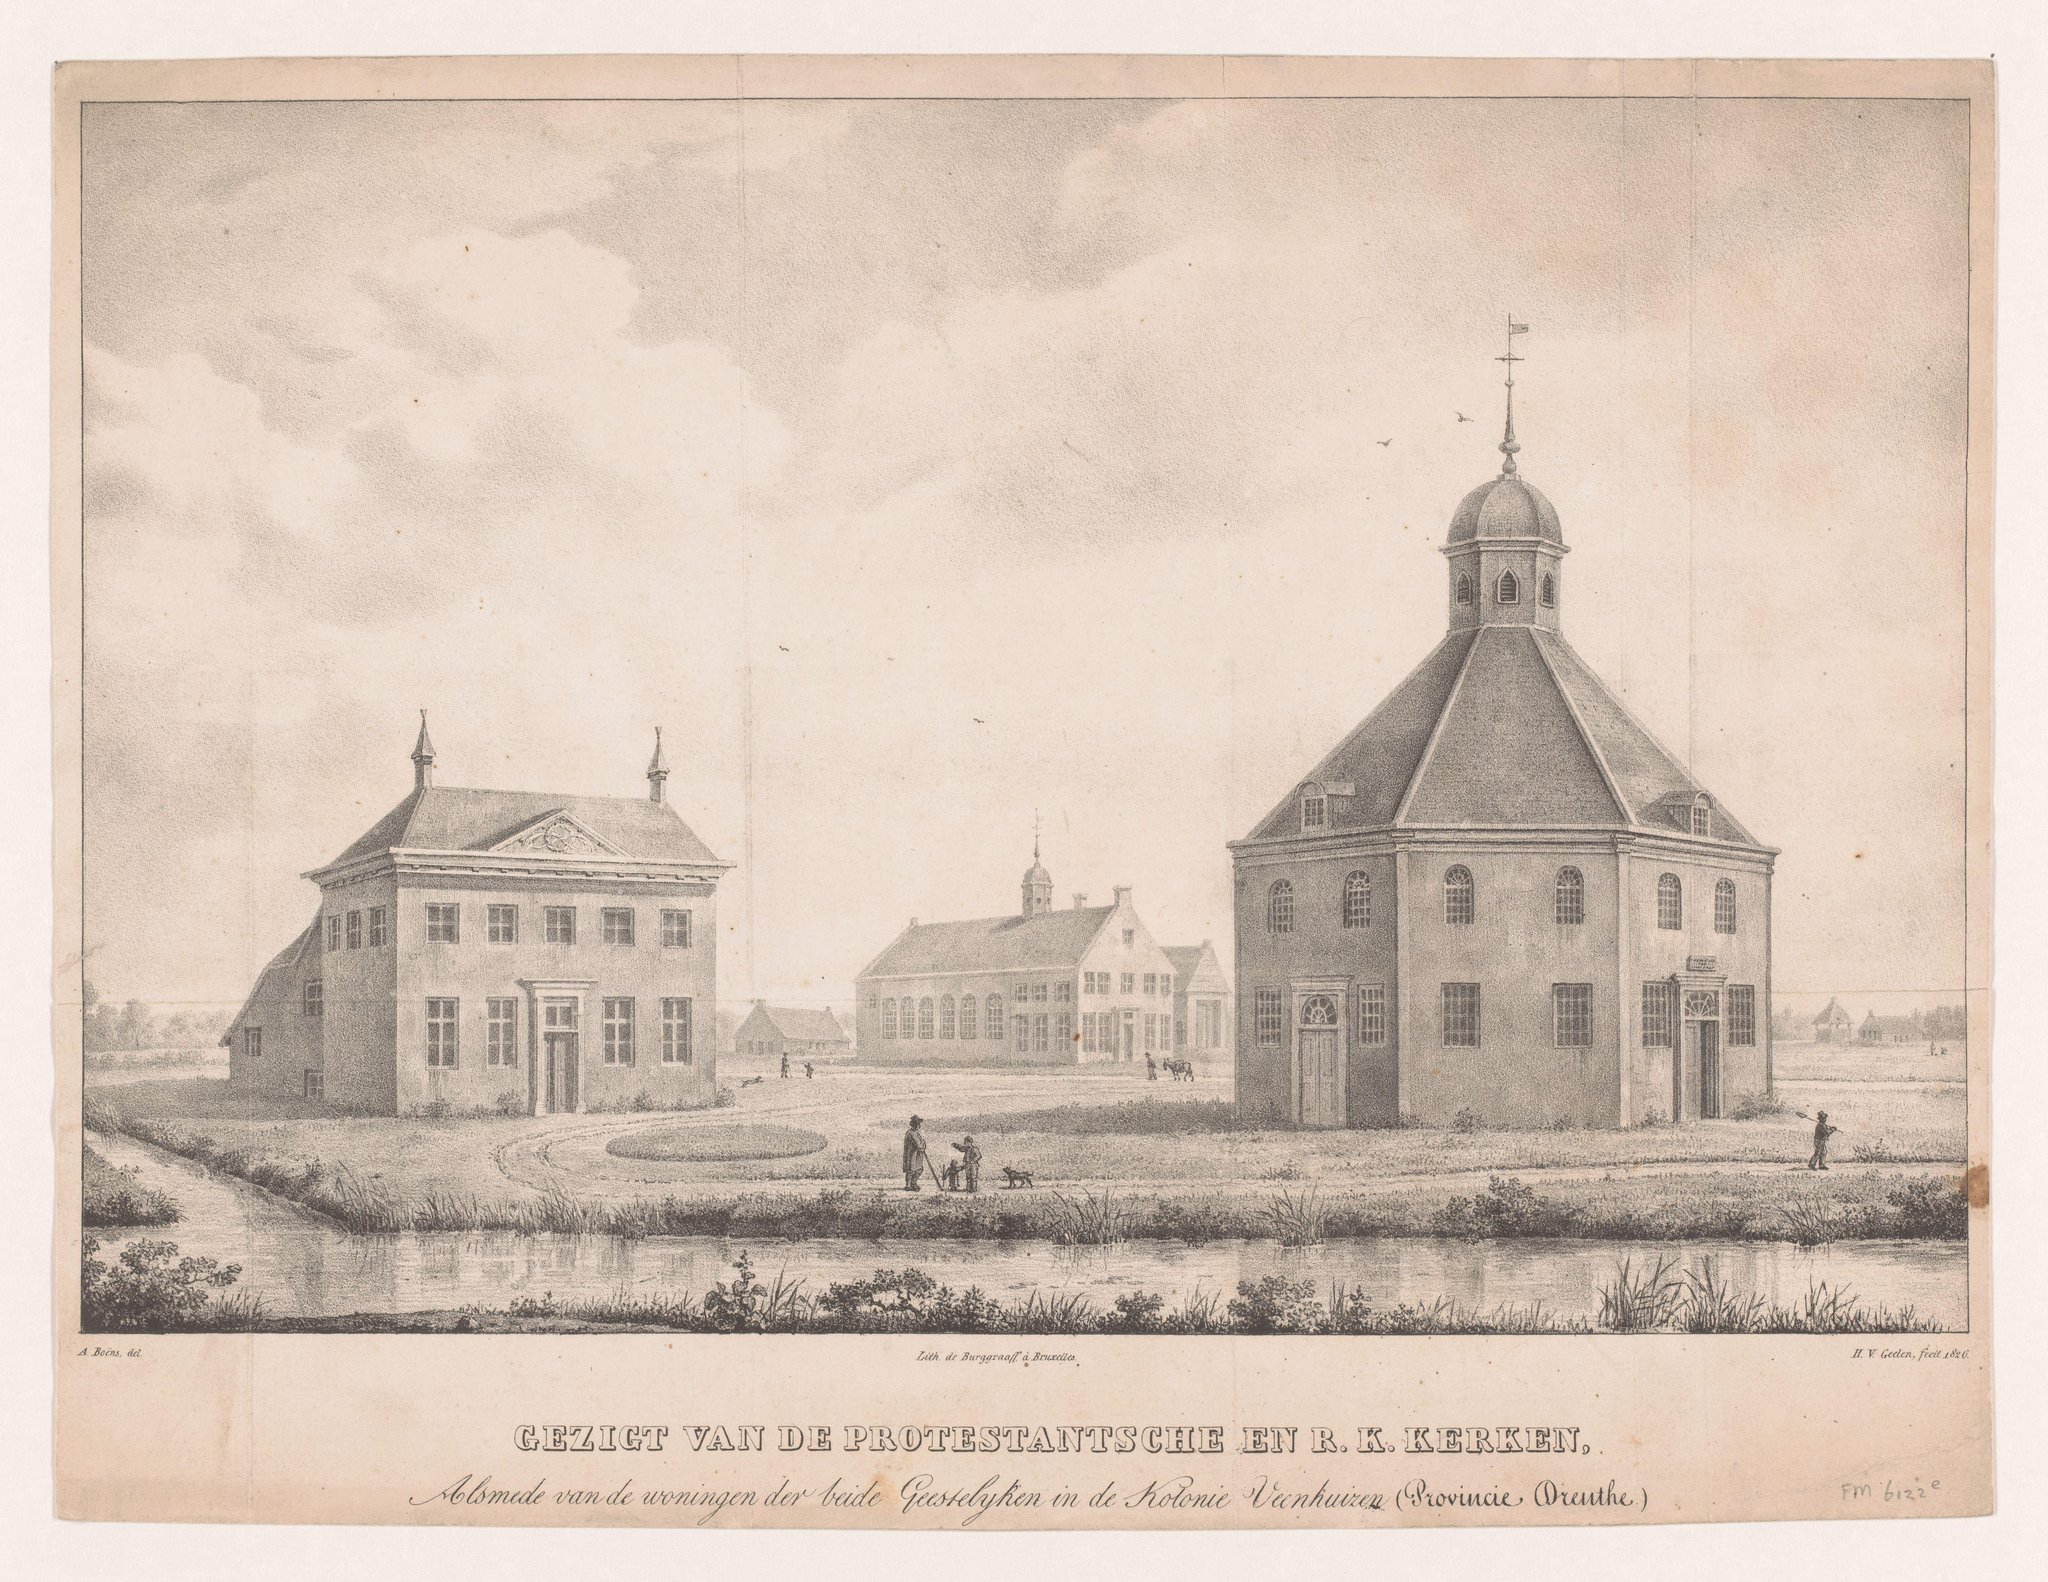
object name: print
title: Gezigt van de Protestantsche en R.K. kerken, alsmede van de woningen der beide geestelijken in de kolonie Veenhuizen (provincie Drenthe)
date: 1827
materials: paper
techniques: lithograph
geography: brussels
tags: maatschappij van weldadigheid, veenhuizen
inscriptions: collector's mark: Lugt 2228